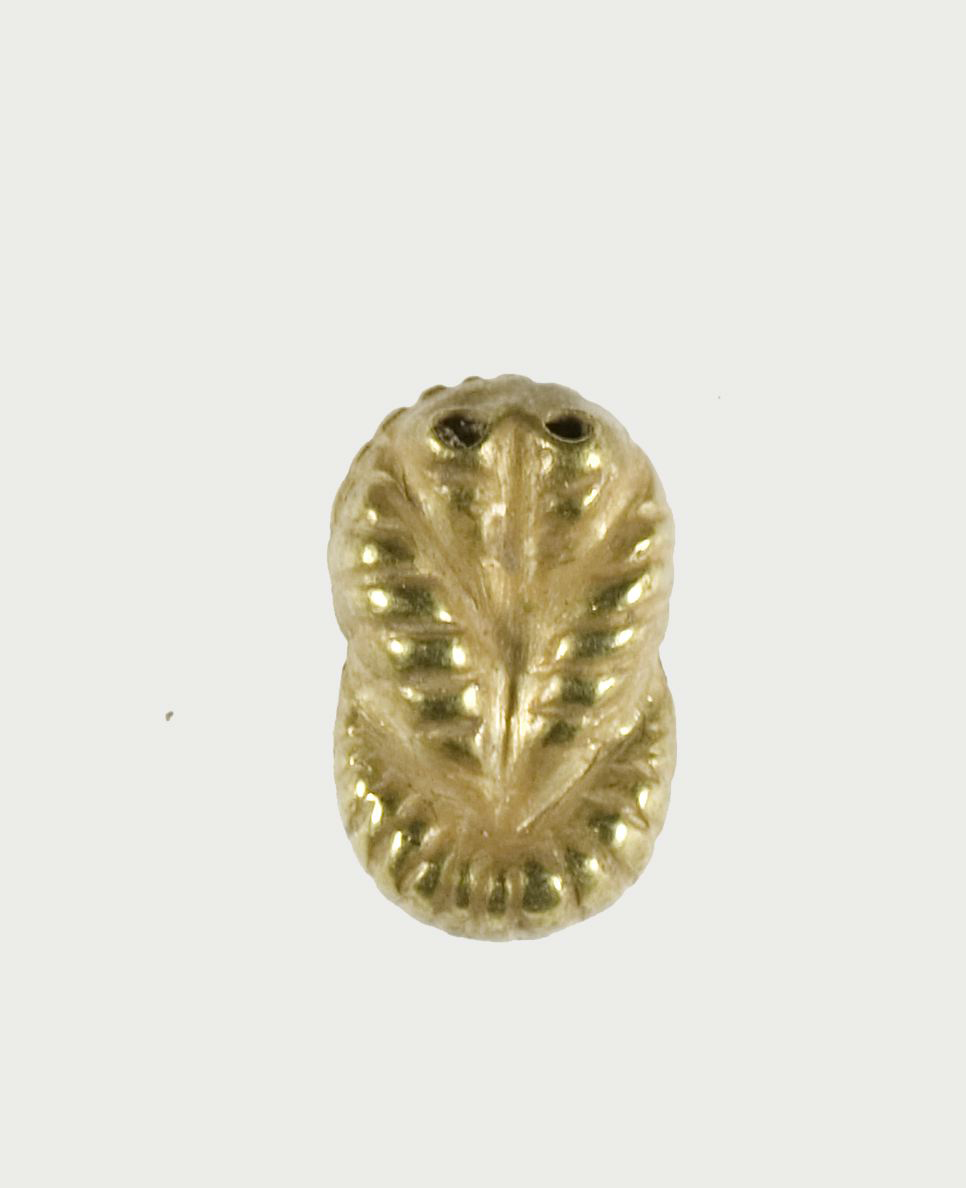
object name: clasp, sithathoryunet, double knot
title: Double knot clasp of Sithathoryunet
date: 1887-1813 BCE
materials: gold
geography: egypt